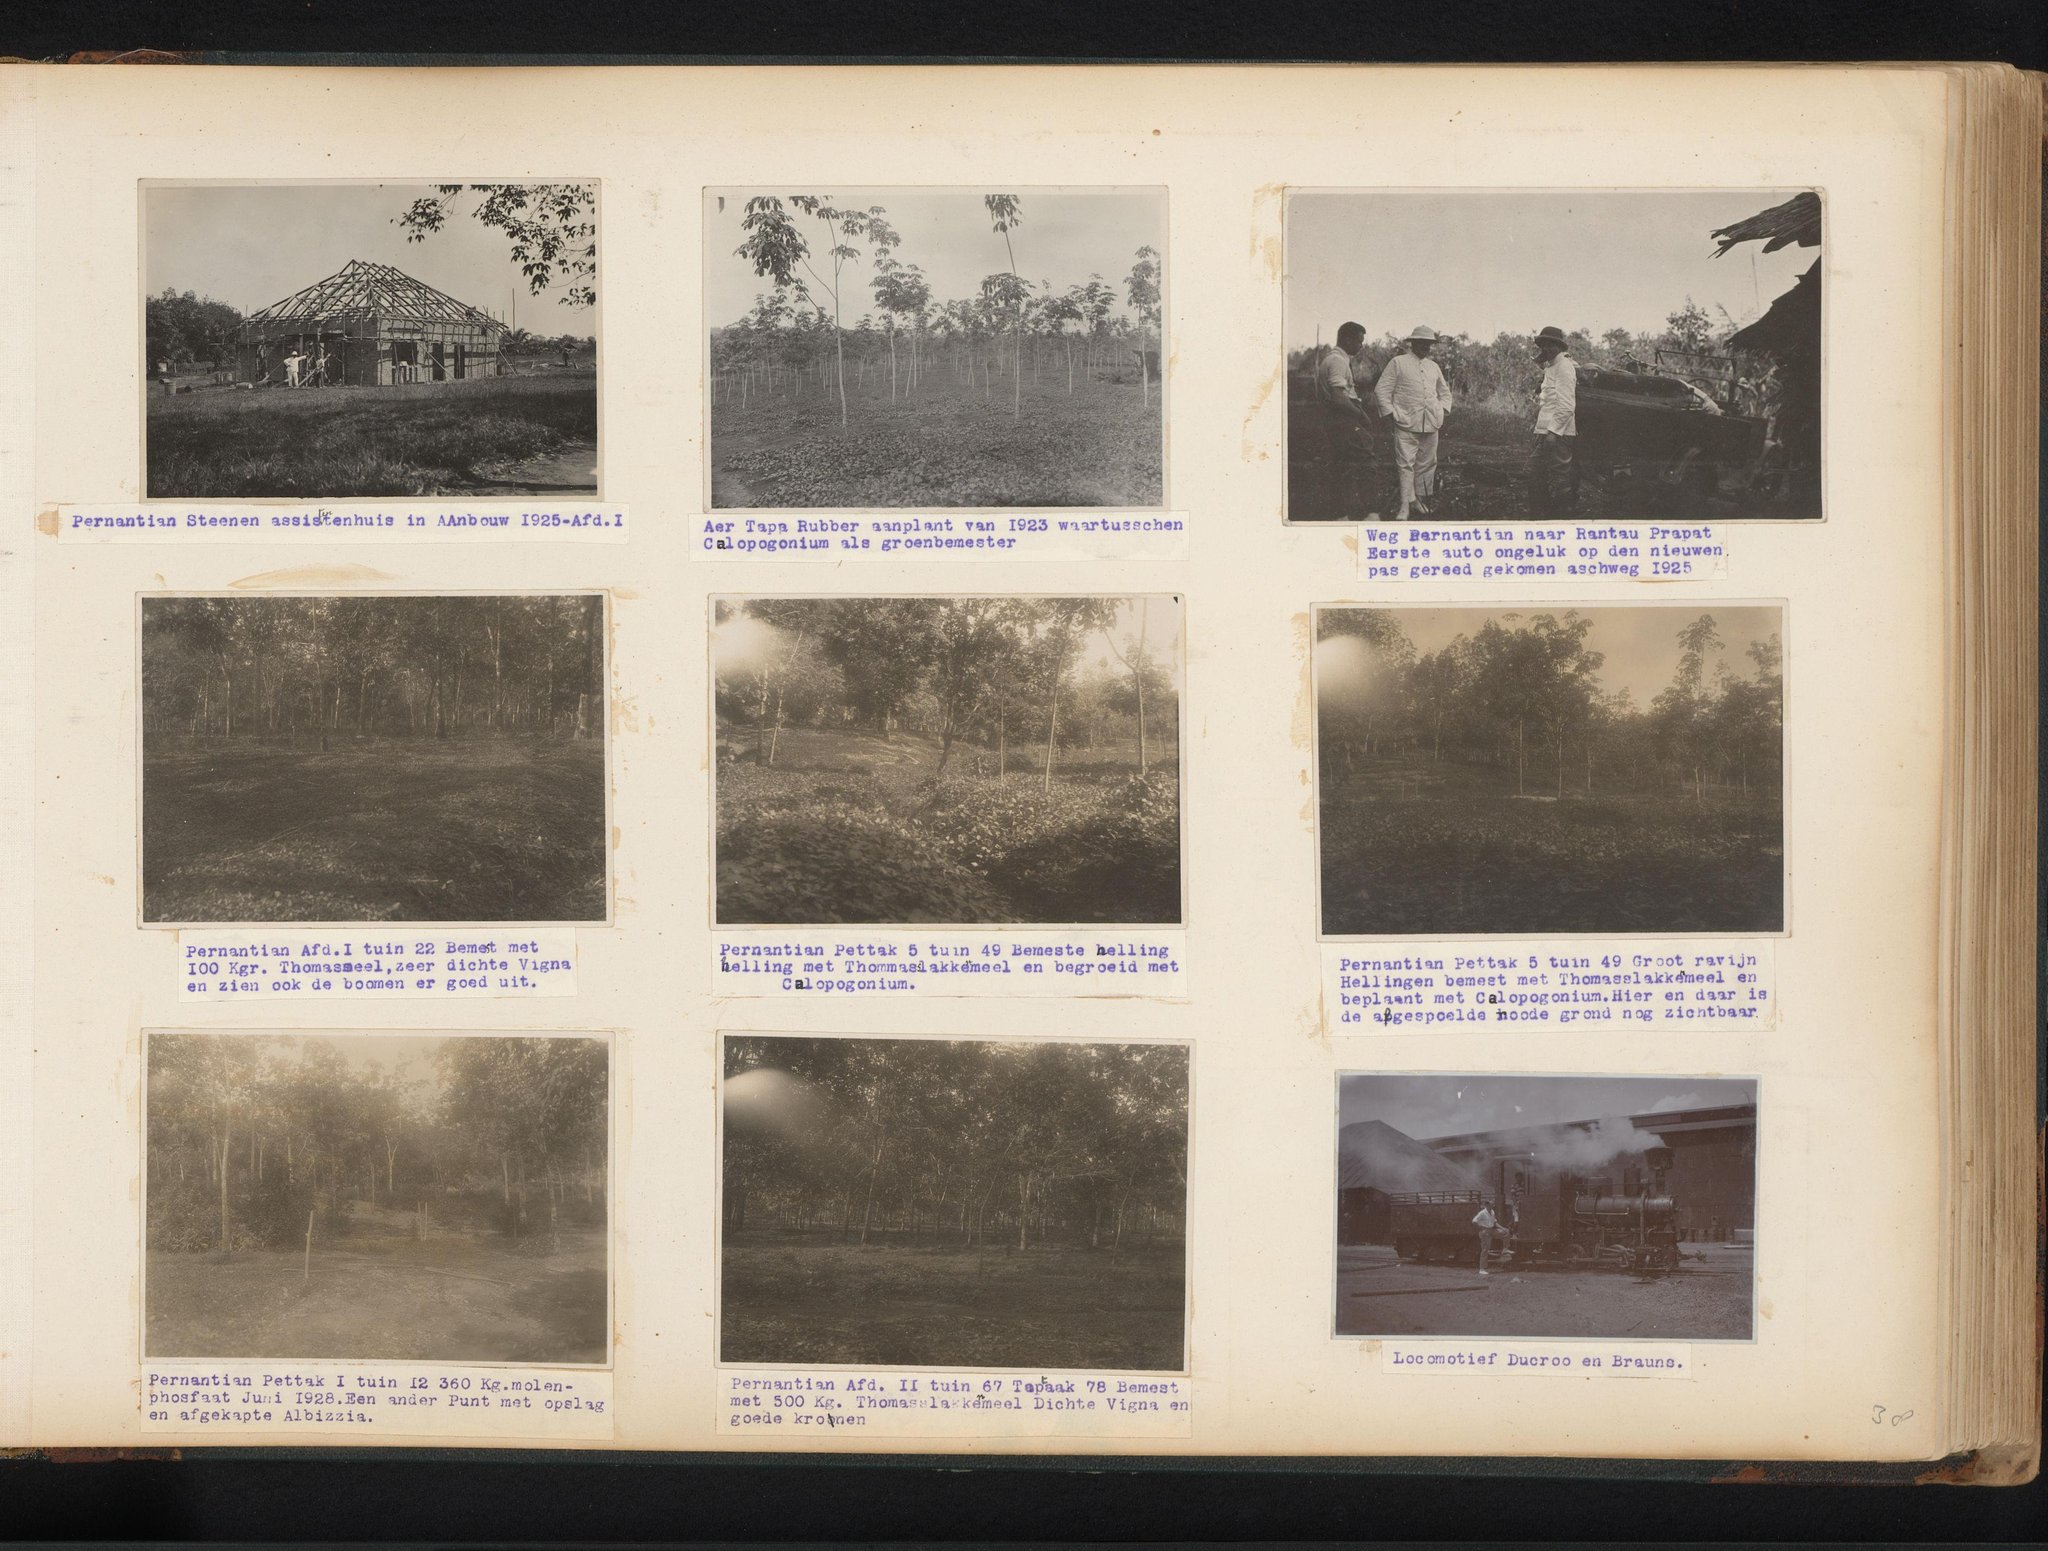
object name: photograph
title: Rubberbomen op Pernantian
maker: Anonymous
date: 1925-1928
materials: cardboard, photographic support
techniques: gelatin silver print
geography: east sumatra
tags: plantation, factory-building, steam locomotive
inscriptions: inscription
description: Blad met negen foto's van rubberbomen en van de aanbouw van een bedrijfsgebouw op Pernantian, ca. 1925-1928, en van een stoomlocomotief op smalspoor van de Nederlandse machinefabriek Du Croo & Brauns. Onder de foto's etiketten met onderschriften. Onderdeel van het fotoalbum over de plantages Brussel en Pernantian van de Sumatra Caoutchouc Maatschappij op de Oostkust van Sumatra in de jaren 1910-1935.